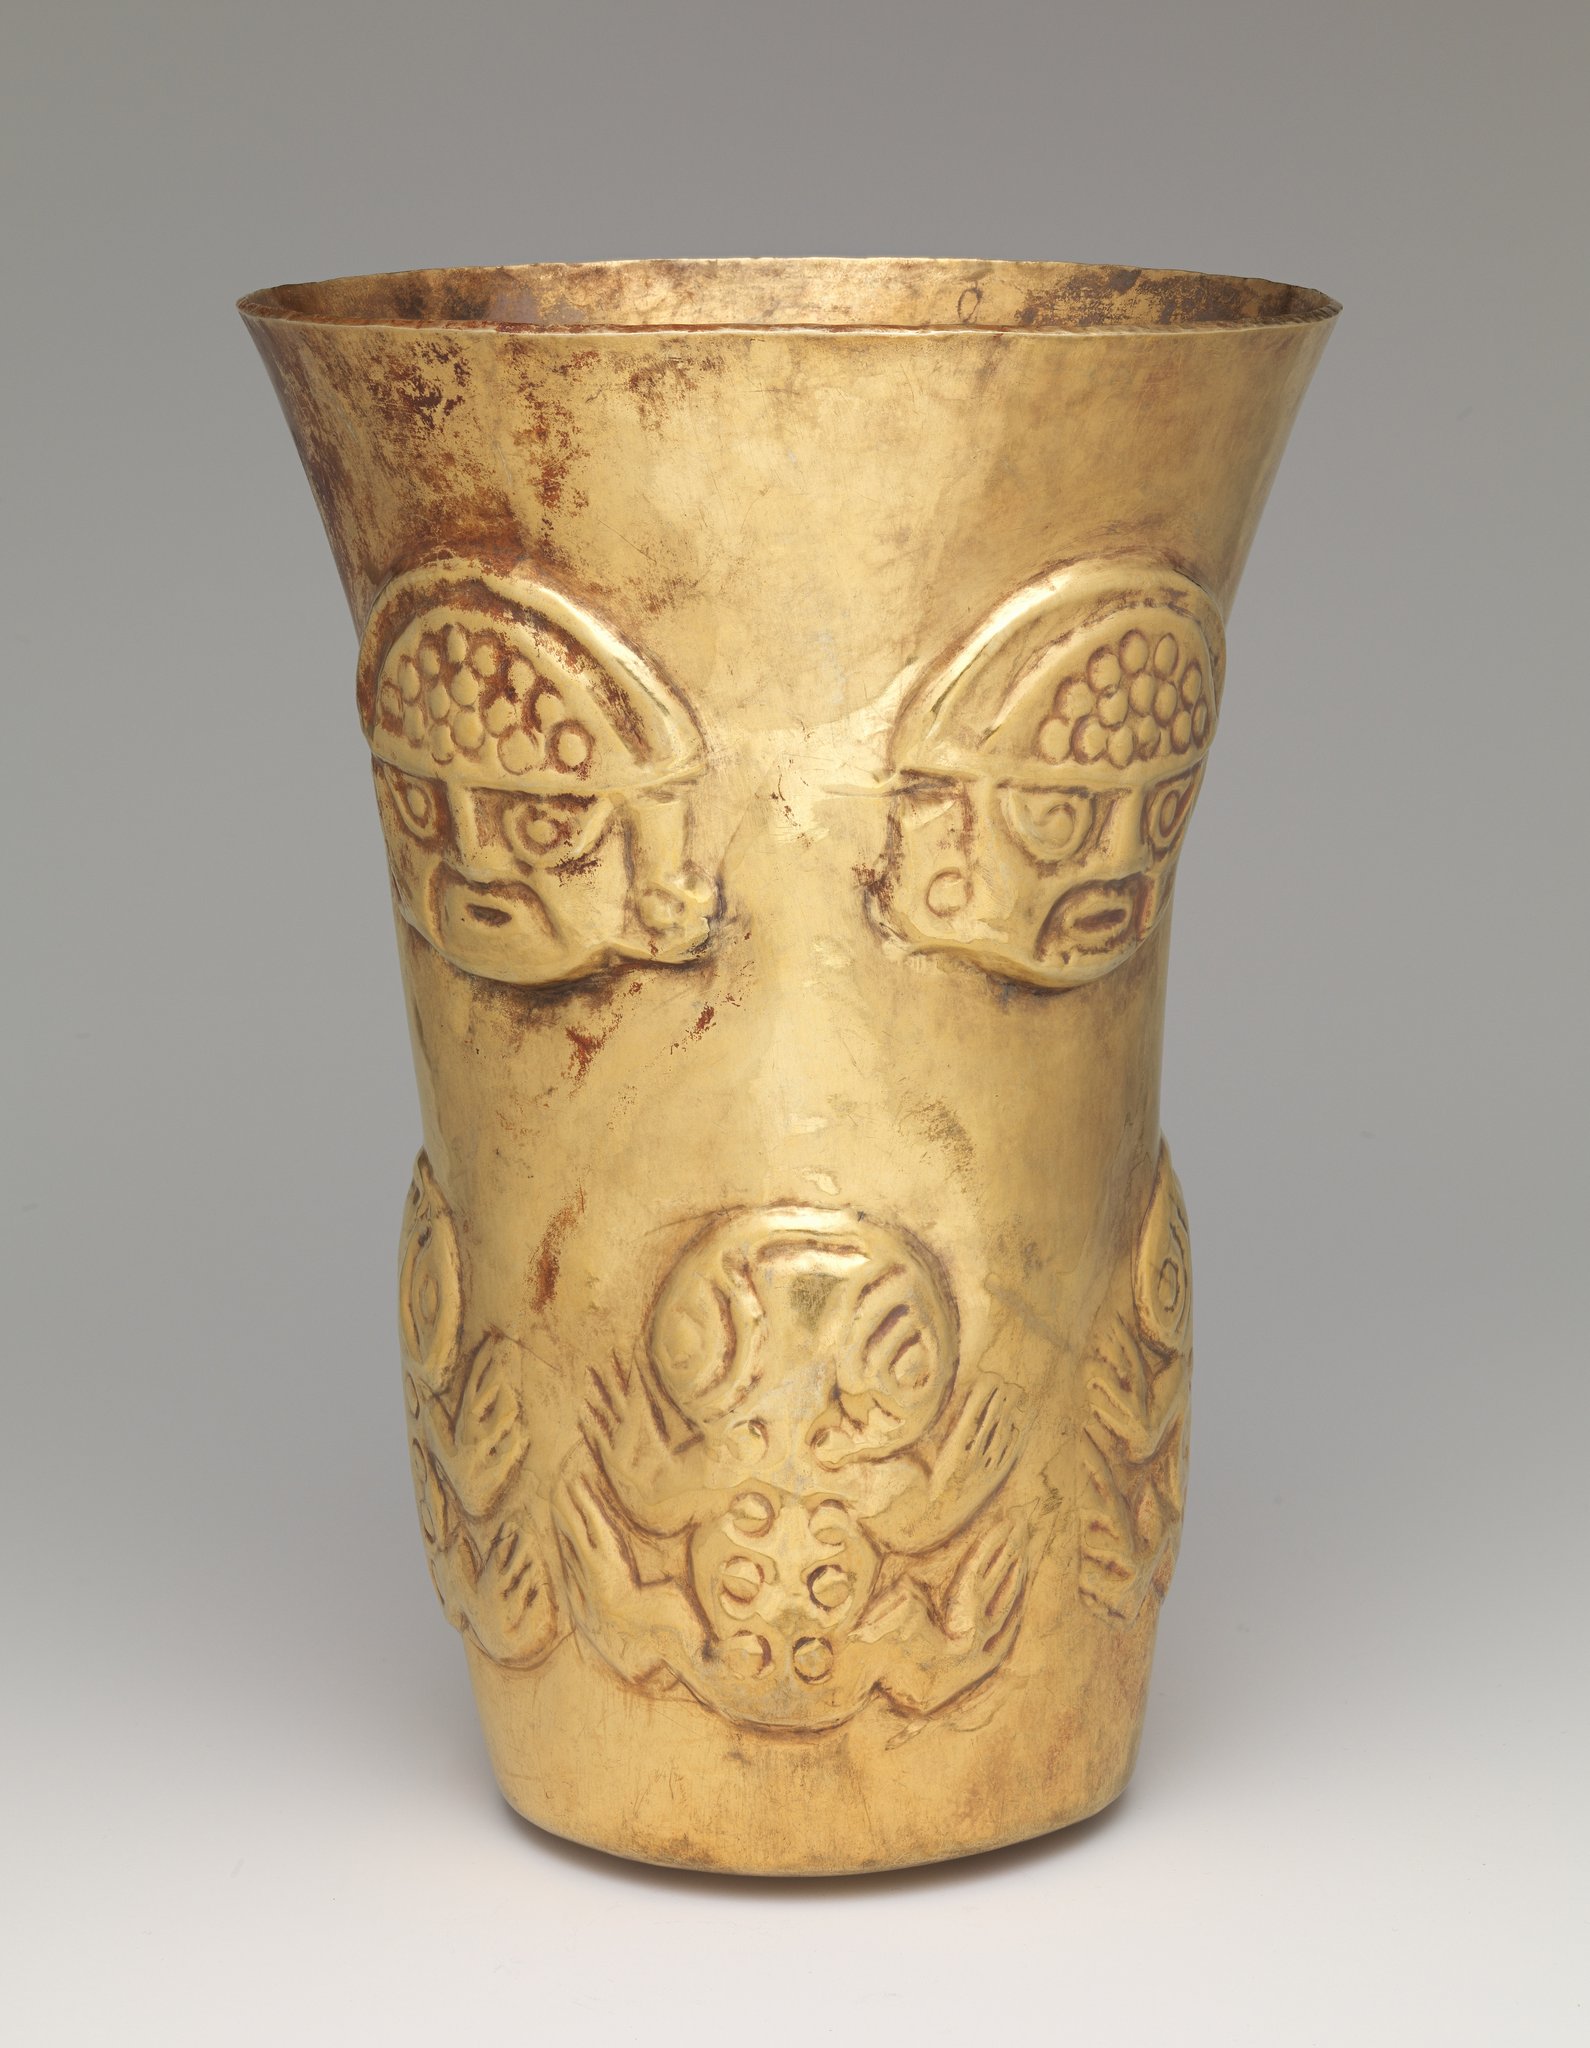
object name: beaker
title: Beaker with heads and toads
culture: lambayeque, sicán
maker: lambayeque (sicán) artist(s)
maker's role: artist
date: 900-1100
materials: gold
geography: peru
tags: faces,frogs